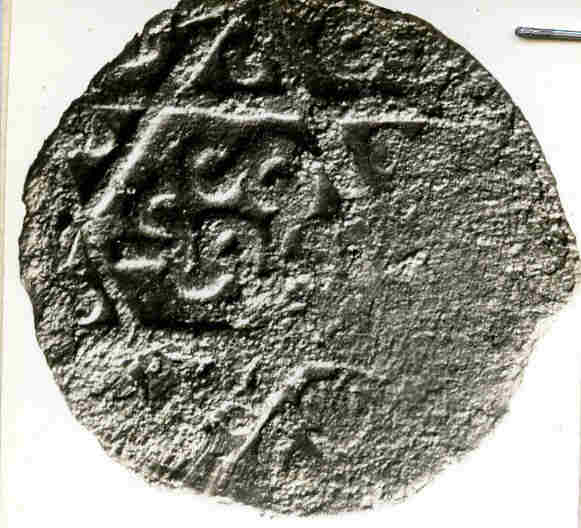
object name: coin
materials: copper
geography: iran